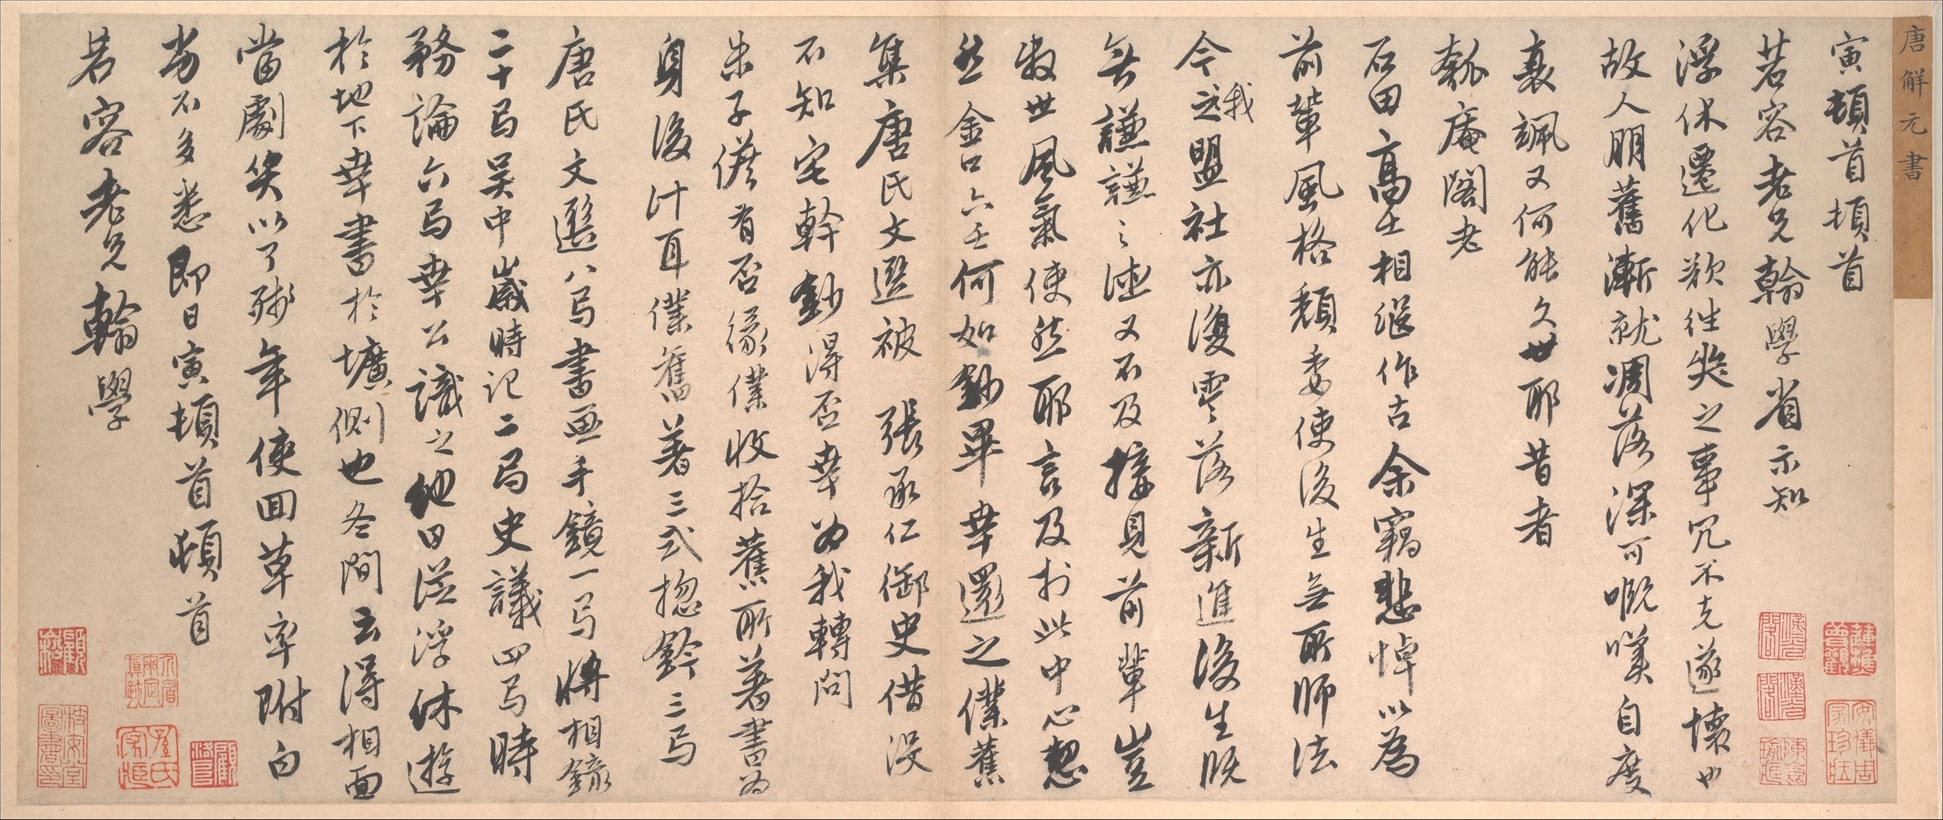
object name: album leaf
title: Letter to Xu Shangde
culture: chinese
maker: tang yin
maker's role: artist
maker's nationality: chinese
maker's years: 1470-1524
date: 1470-1524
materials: ink, paper